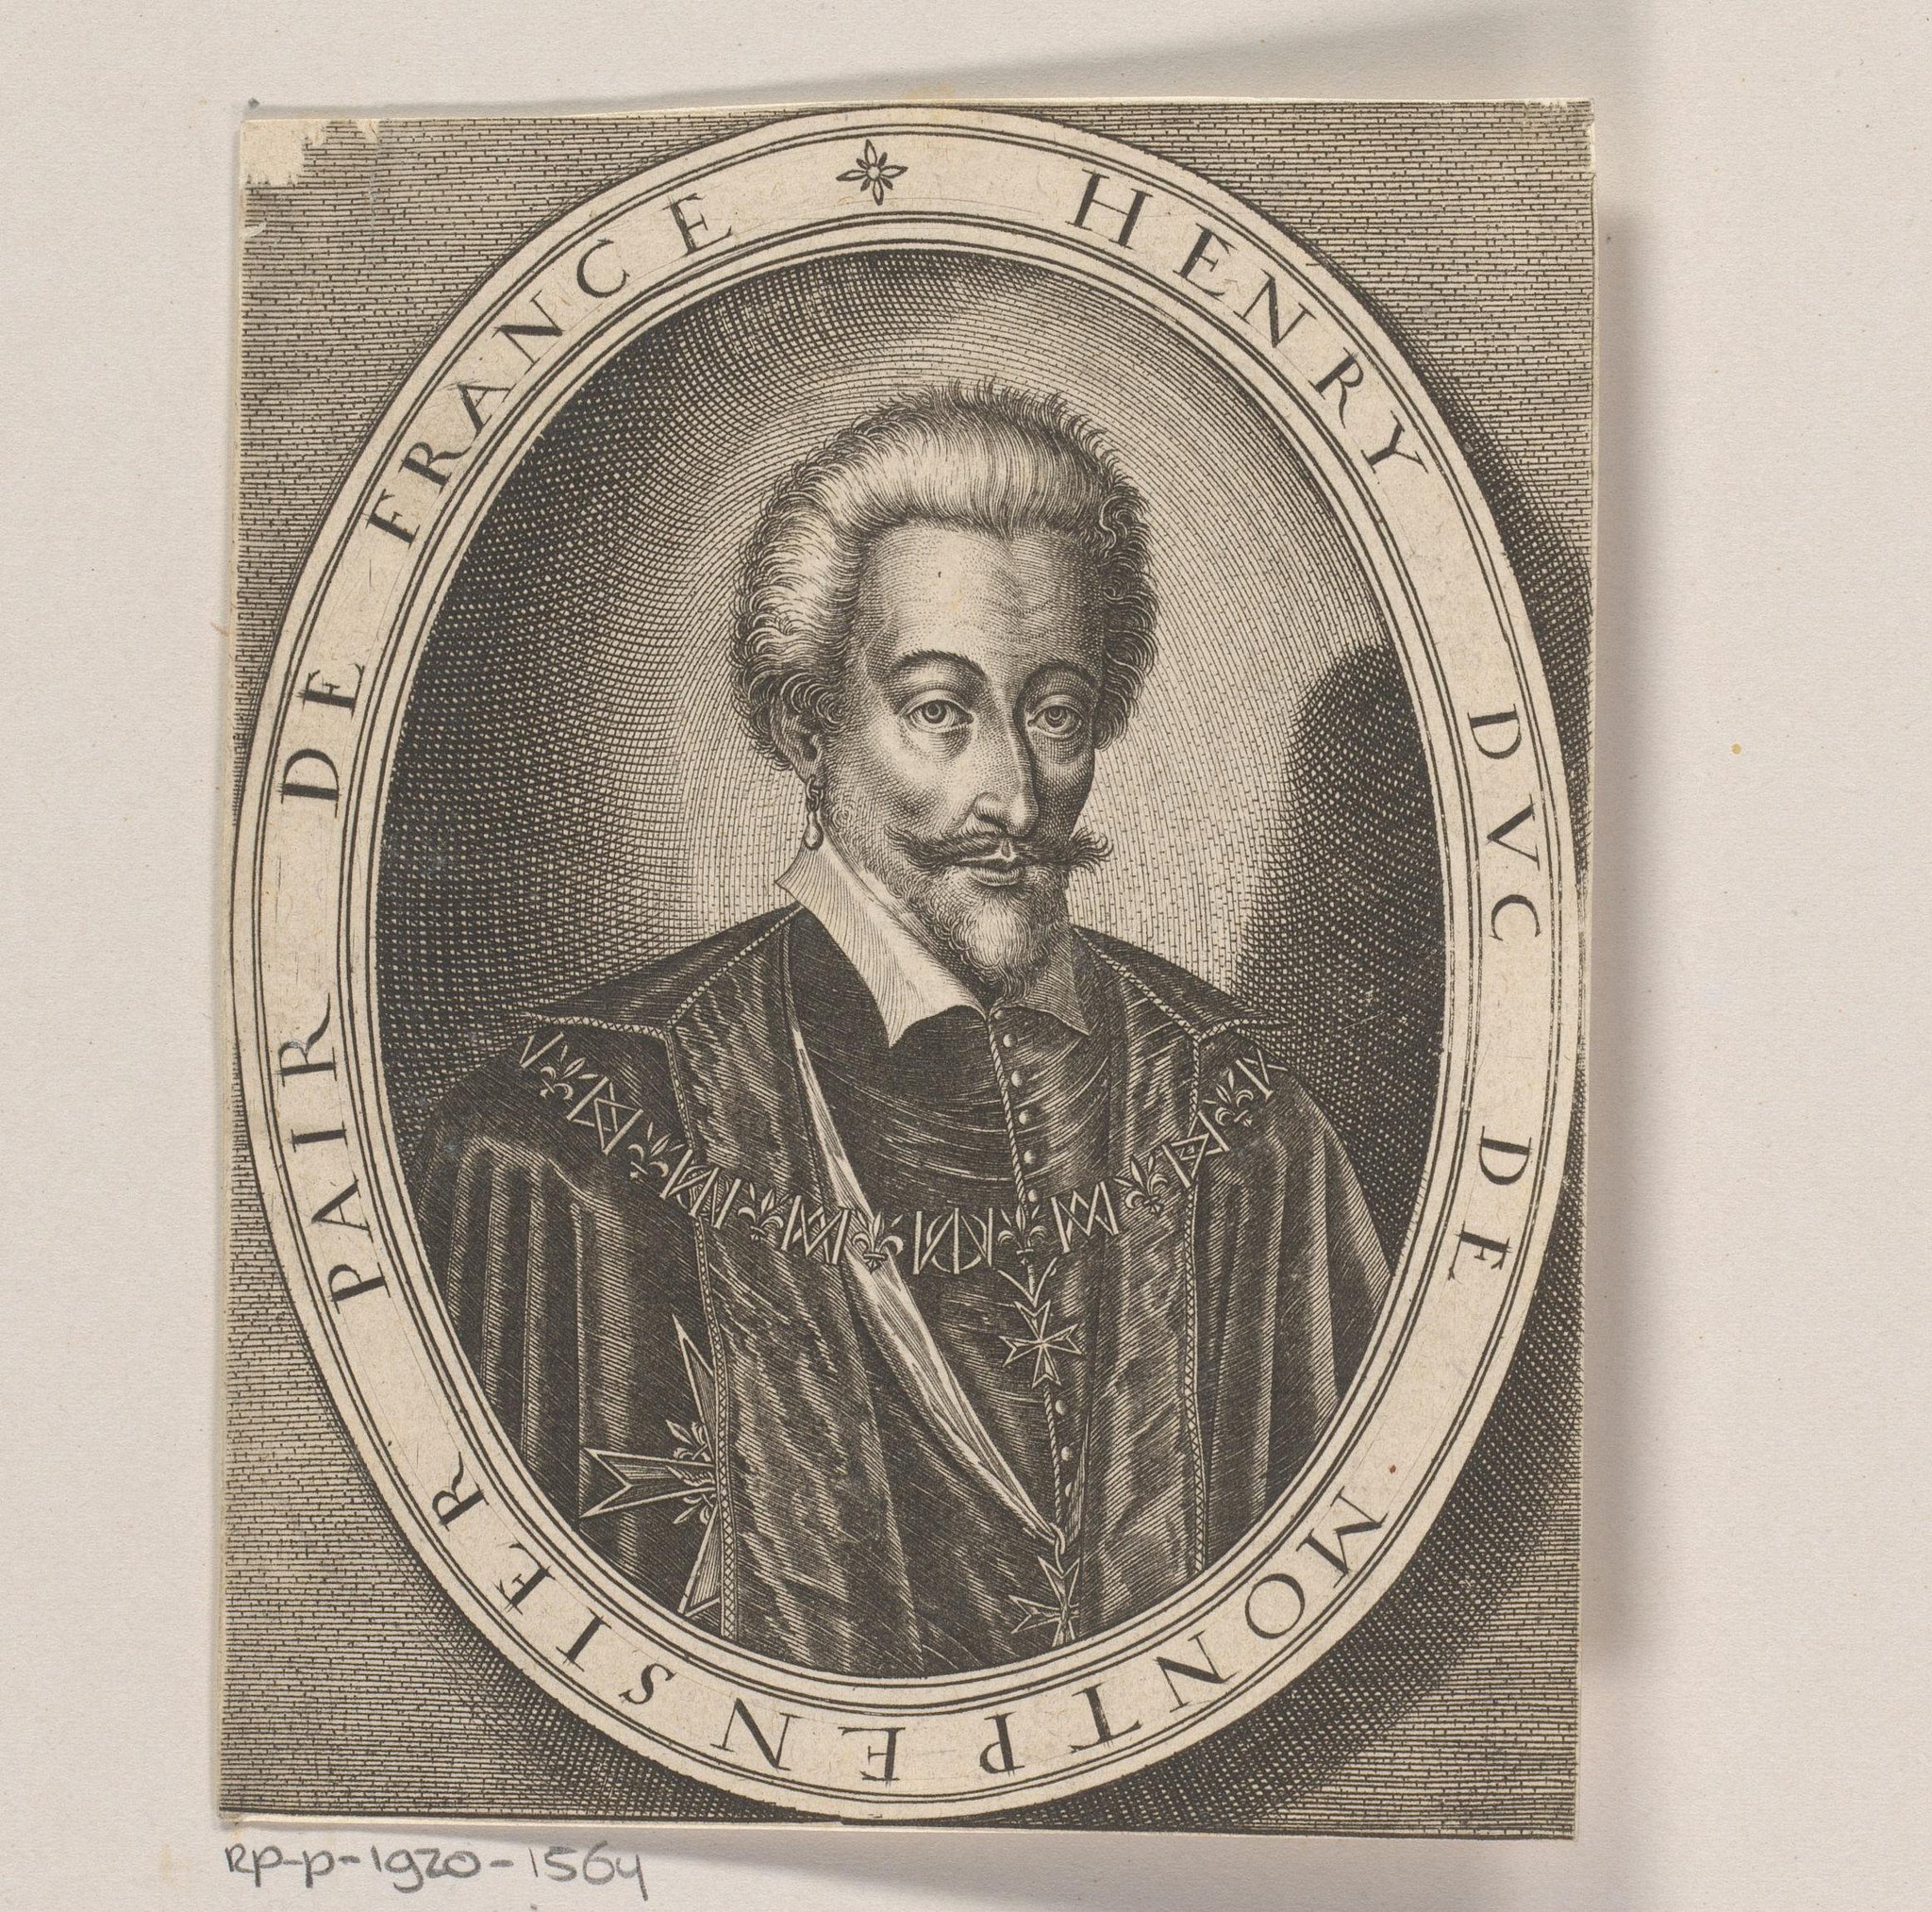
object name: print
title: Henry Duc de Montpensier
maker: Anonymous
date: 1592-1660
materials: paper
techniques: engraving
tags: historical persons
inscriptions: collector's mark: Lugt 2228